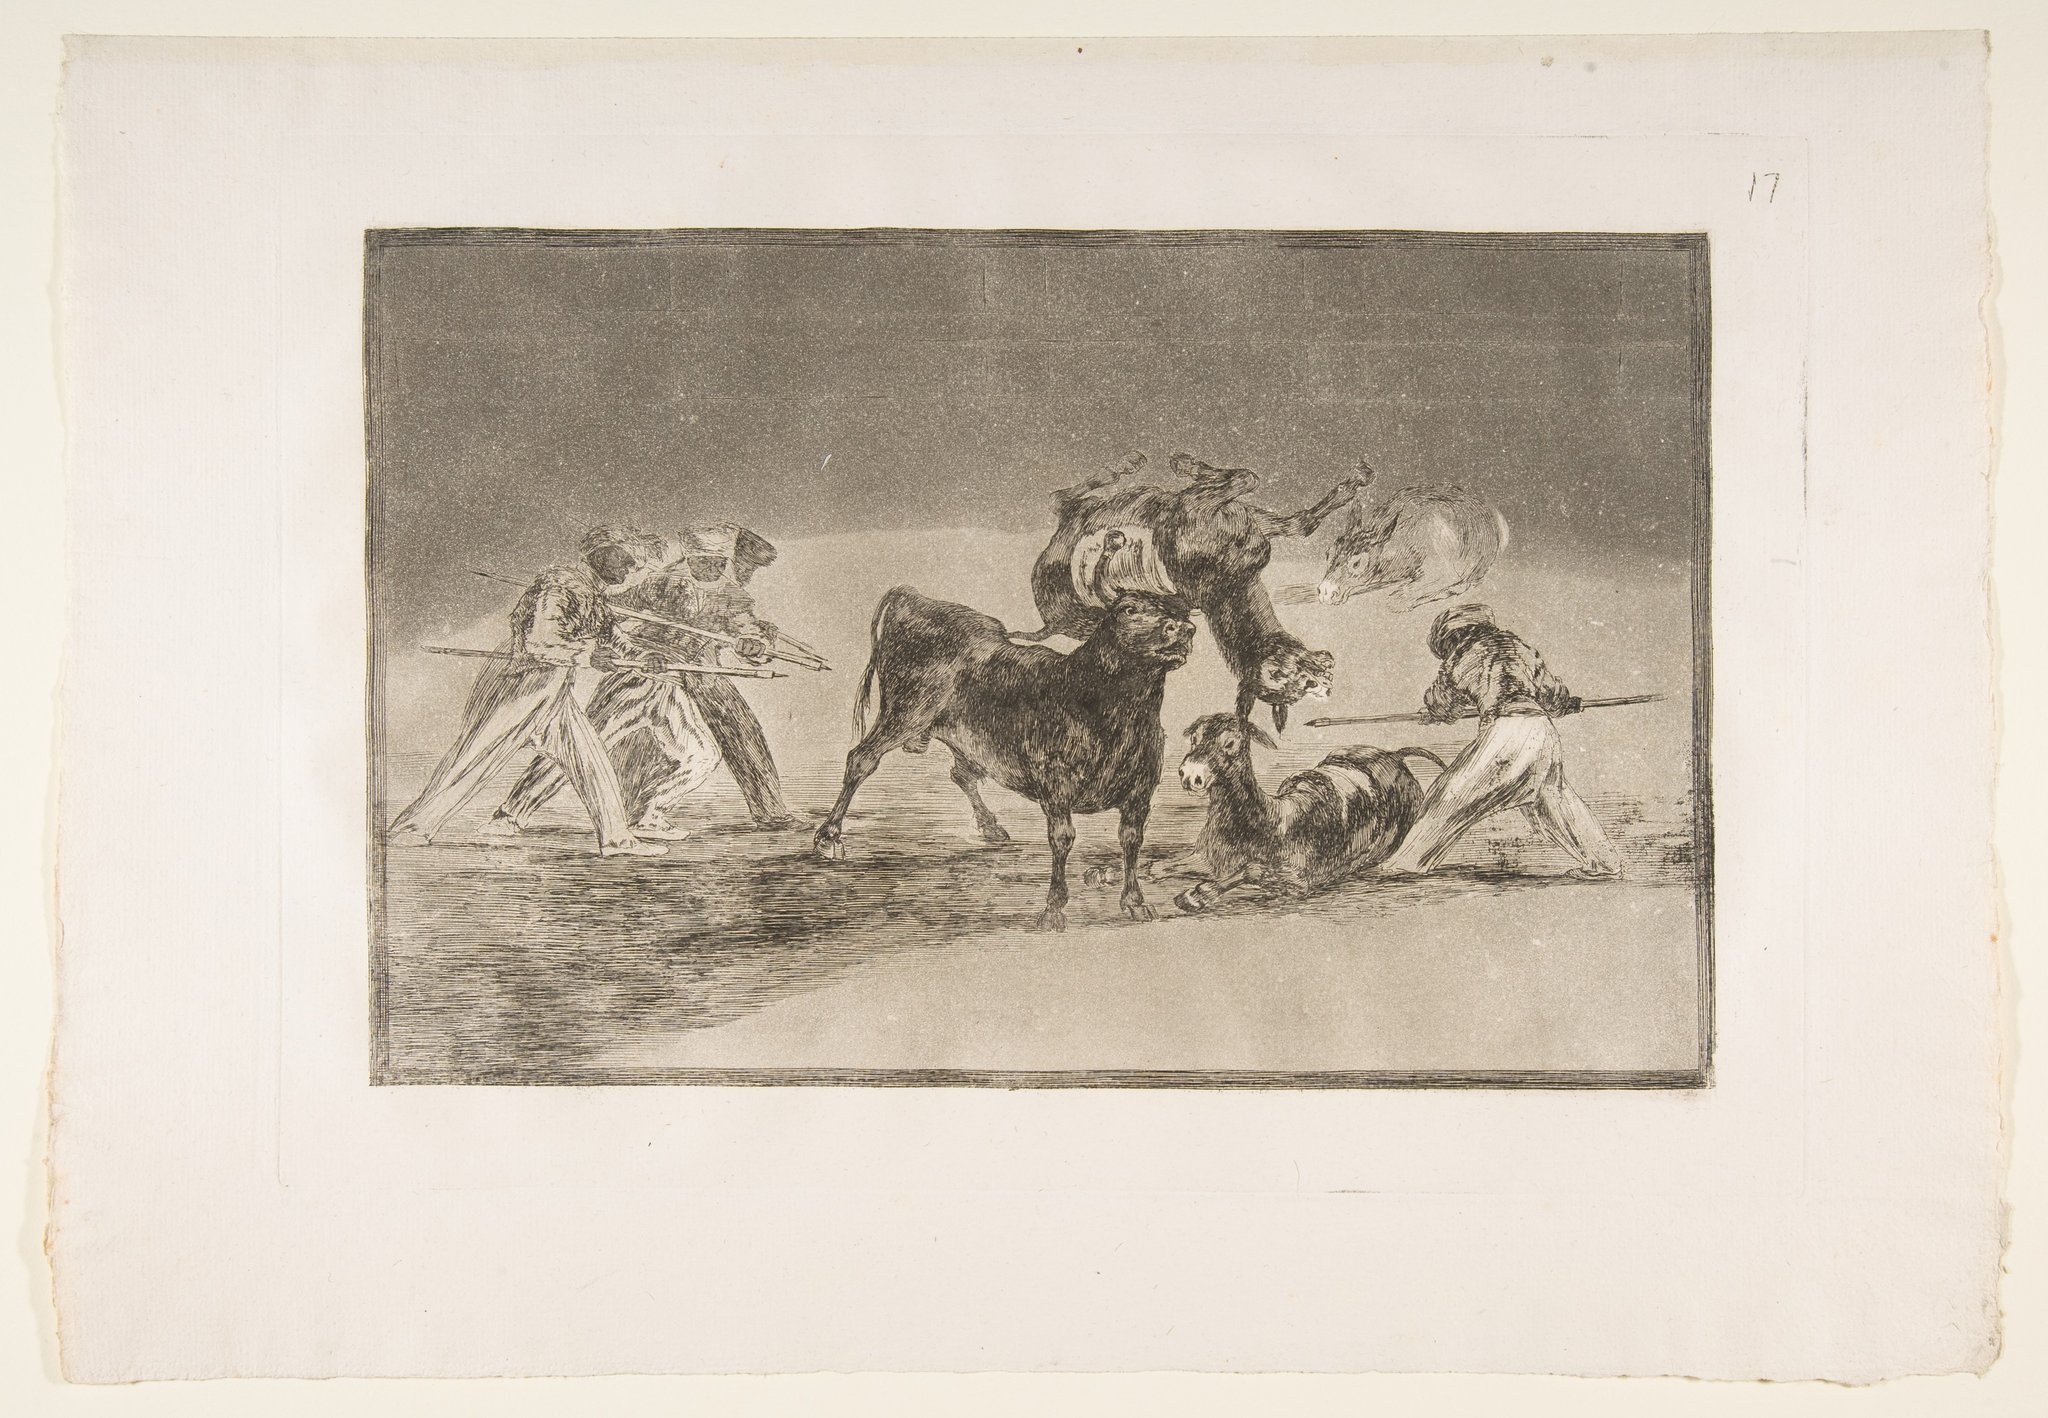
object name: print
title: Plate 17 of "La Tauromaquia": The Moors use donkeys as a barrier to defend themselves against the bull whose horns have been tipped with balls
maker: goya (francisco de goya y lucientes)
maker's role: artist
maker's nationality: spanish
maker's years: 1746-1828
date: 1816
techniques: aquatint, engraving, burnishing, drypoint, etching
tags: weapons,men,bulls,donkeys